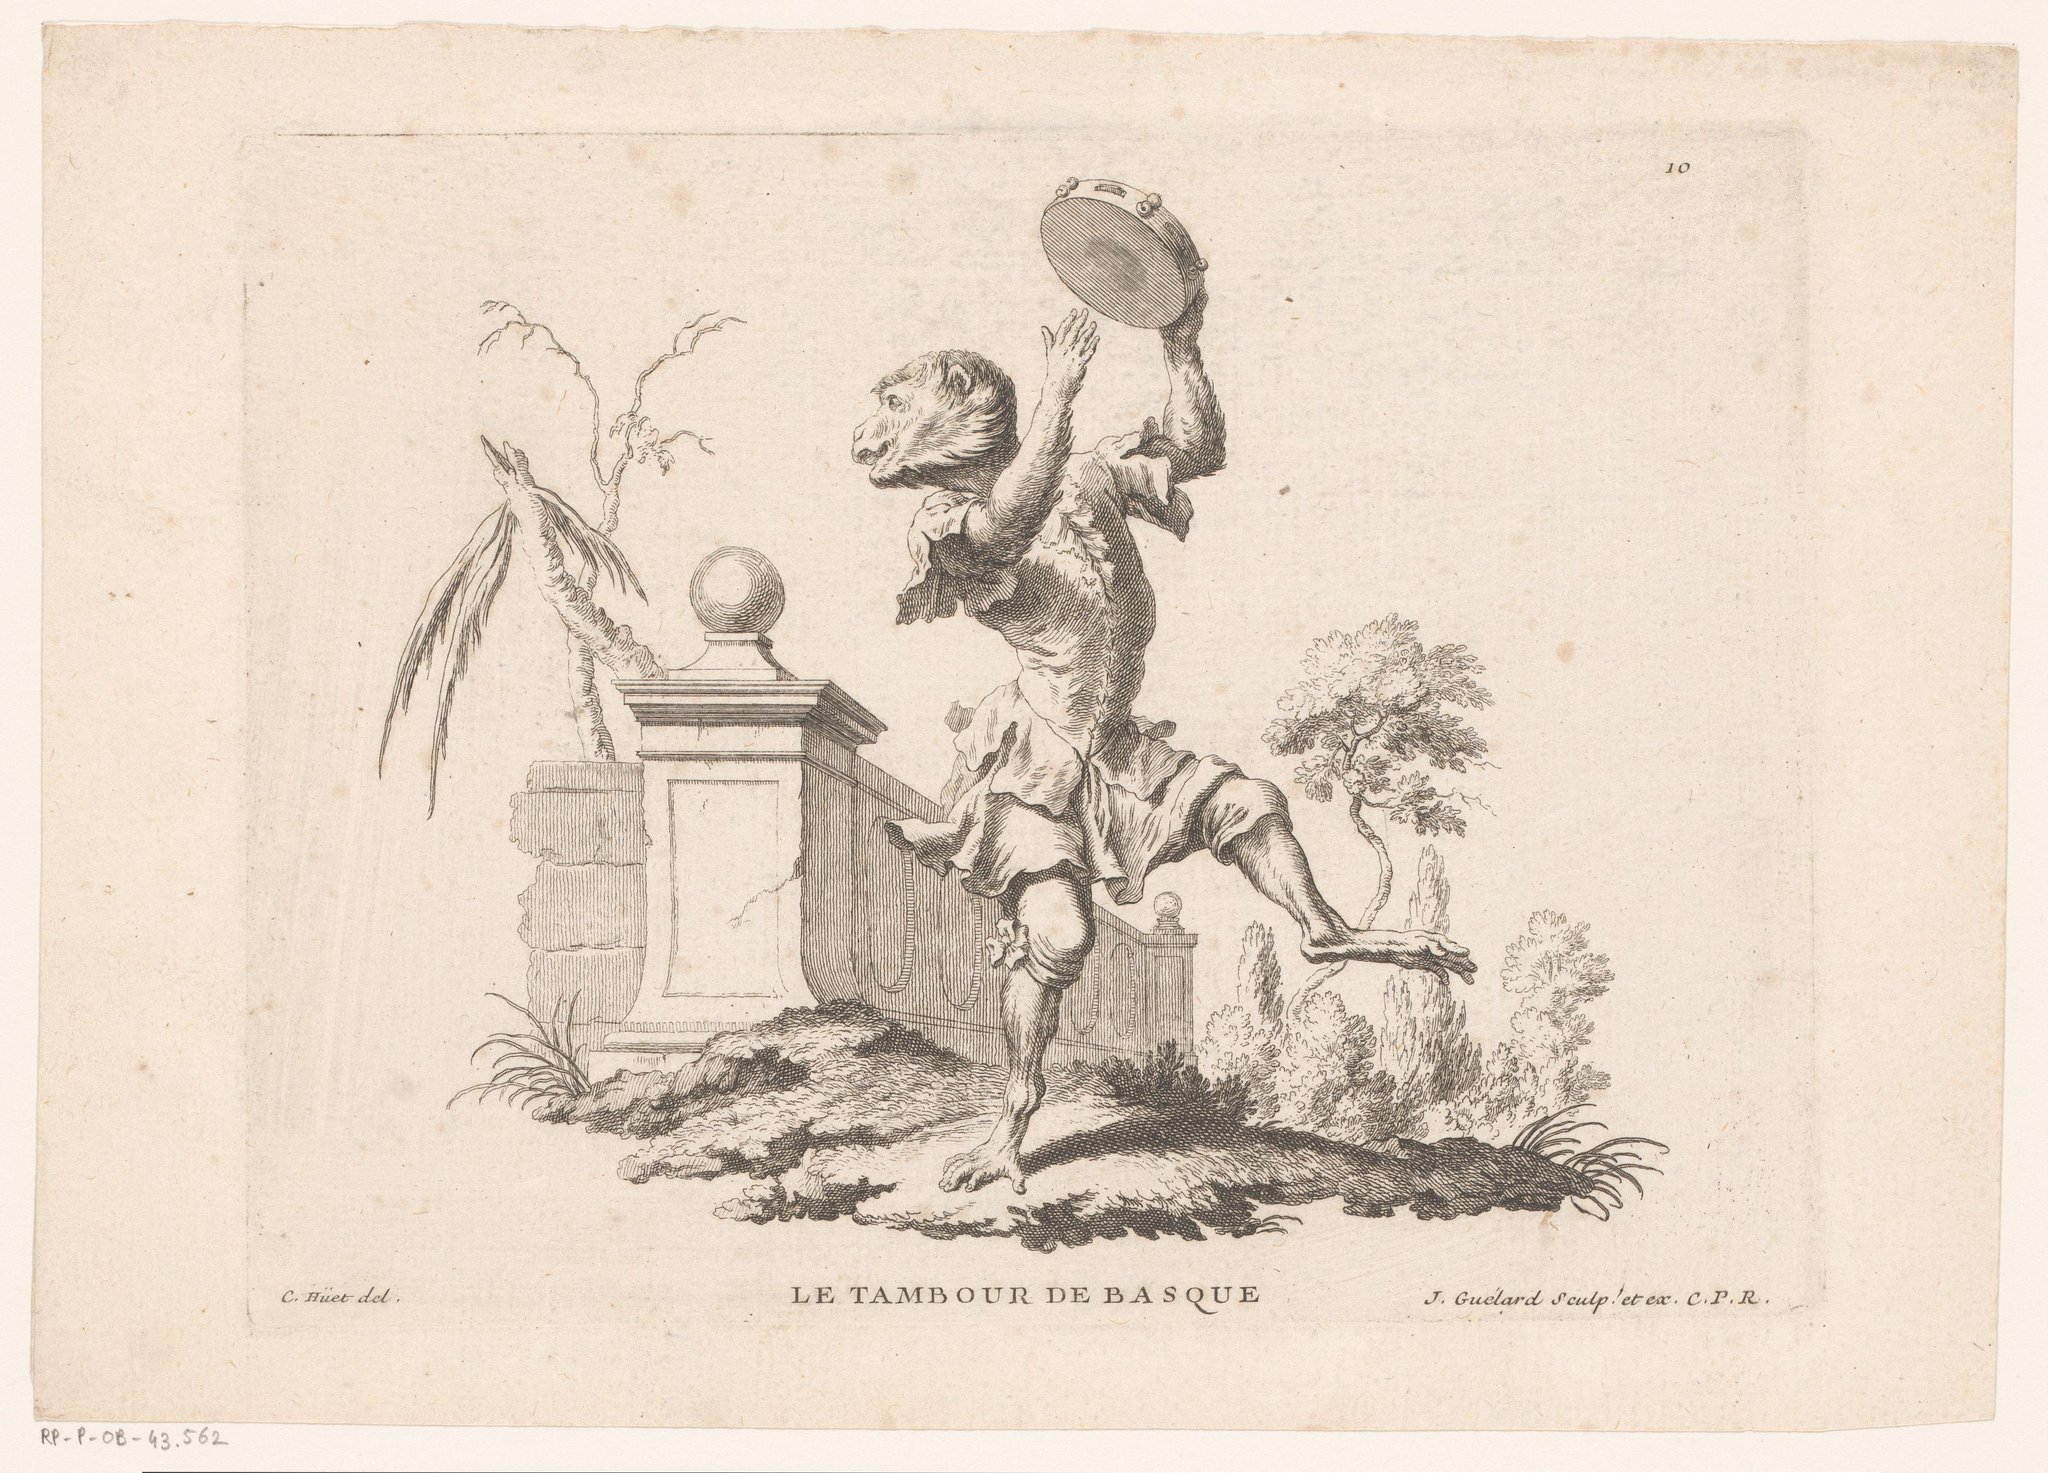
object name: print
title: Apenspel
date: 1733-1792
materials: paper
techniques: etching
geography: paris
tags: monkeys, apes, animals acting as human beings, tambourine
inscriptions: collector's mark: Lugt 2228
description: Maakt deel uit van een twaalfdelige serie getiteld 'Singeries ou differentes Actions de la Vie humaine', met apenspelen. De serie bestaat uit twee delen met elk twaalf platen en een opdracht. Deze serie is opgedragen aan het publiek (Au Public). Het andere deel werd opgedragen aan Monsieur de l'Orme van de Ménagerie de Versailles. De serie werd initieel uitgegeven door Guélard en de weduwe van Chéreau. Dit betreft waarschijnlijk een door het IFF onbeschreven latere staat, uitgegeven door Étienne Charpentier.